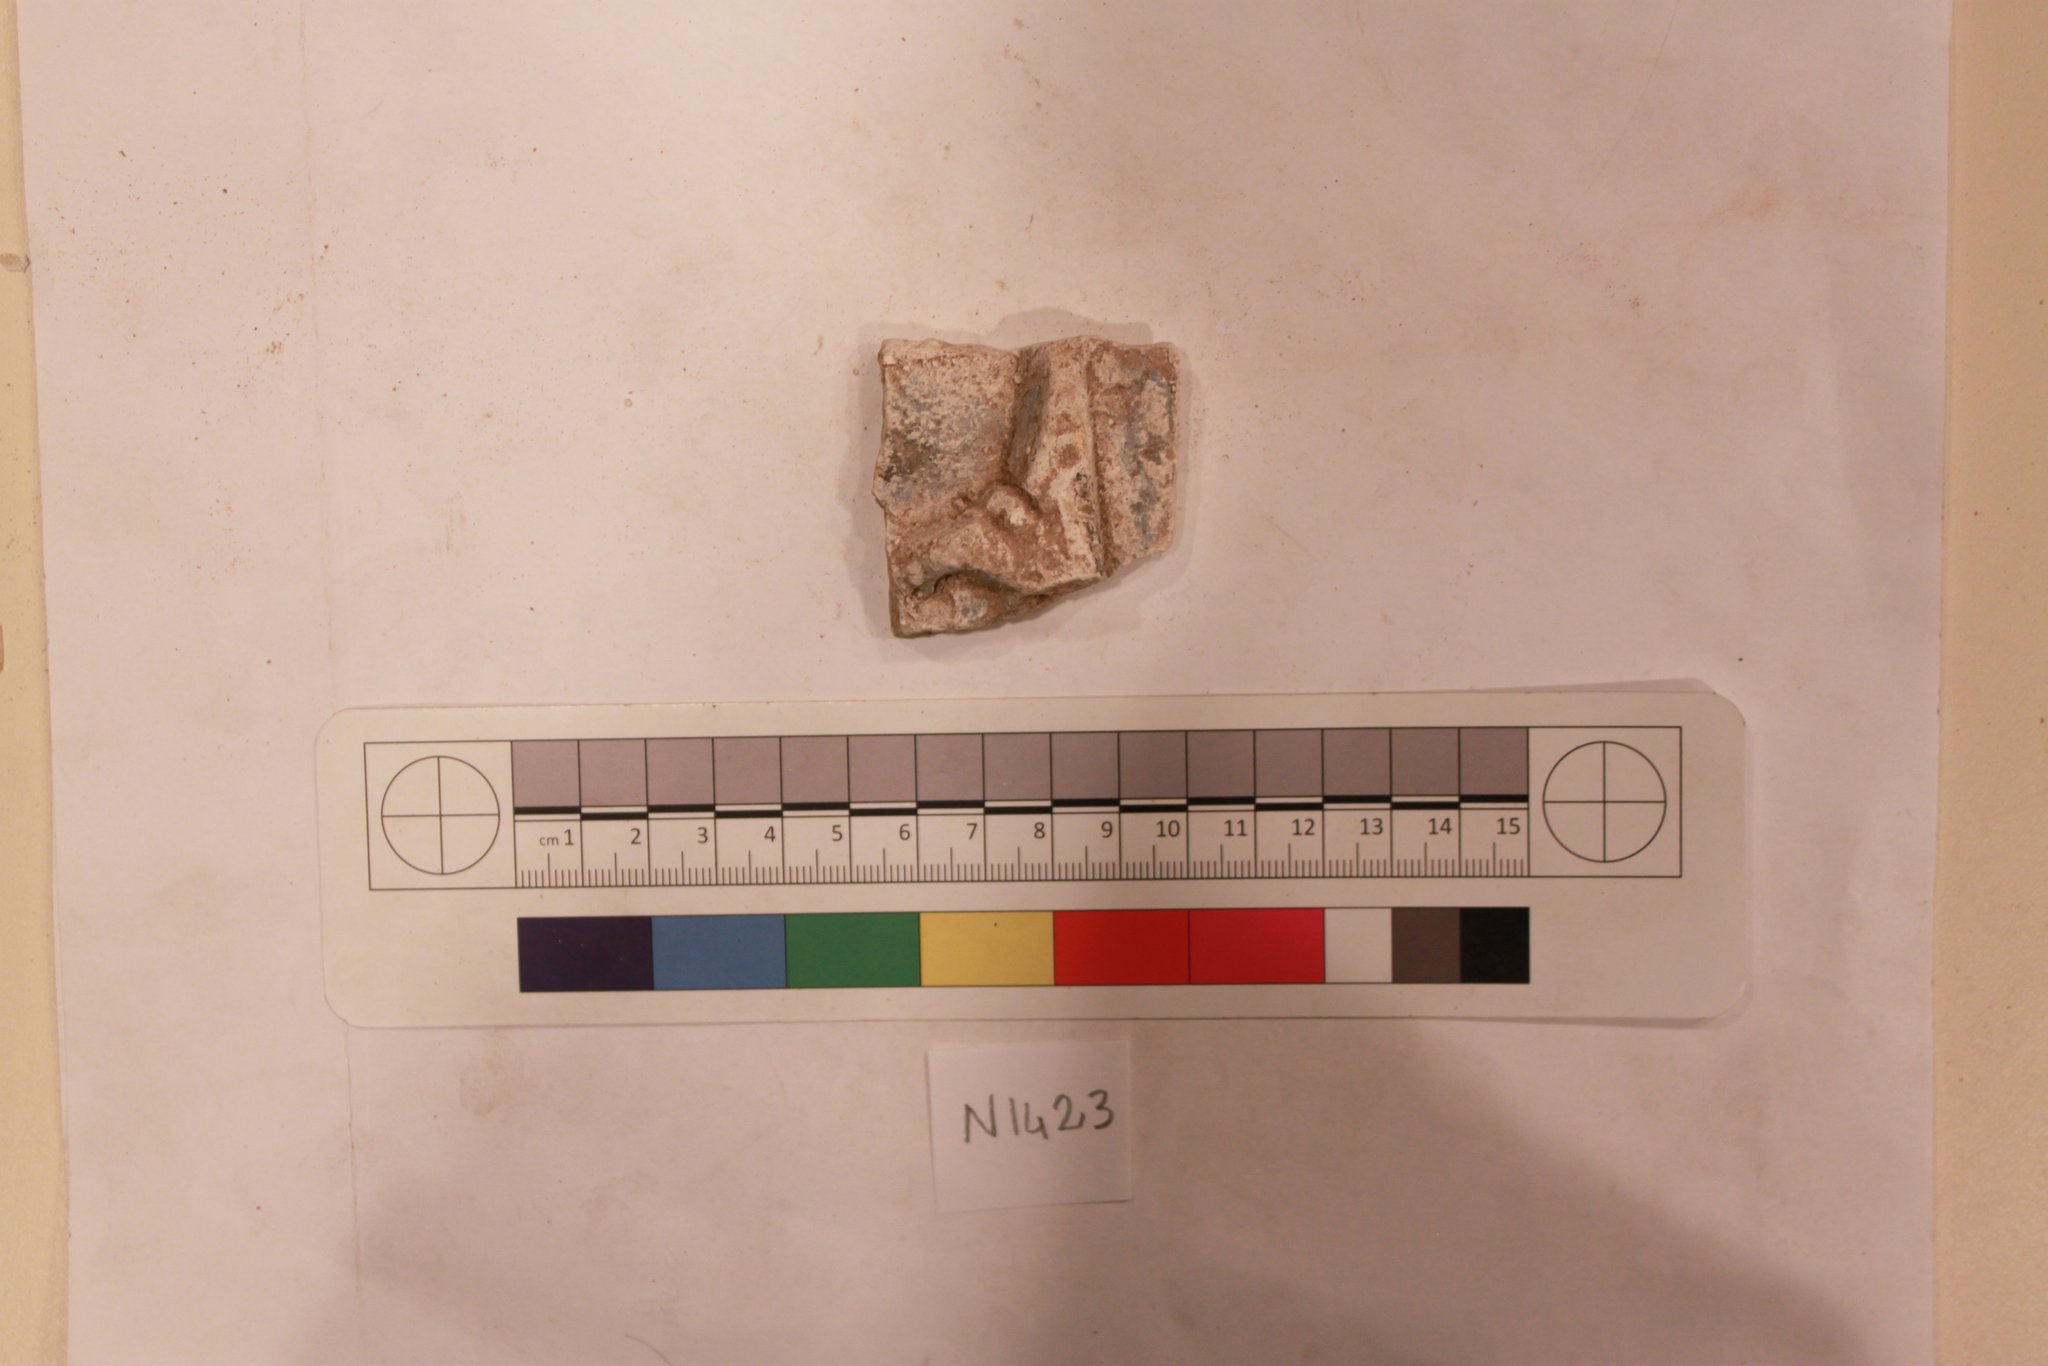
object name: fragment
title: Stucco Fragment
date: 701-1200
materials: plaster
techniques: carving, painting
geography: iran